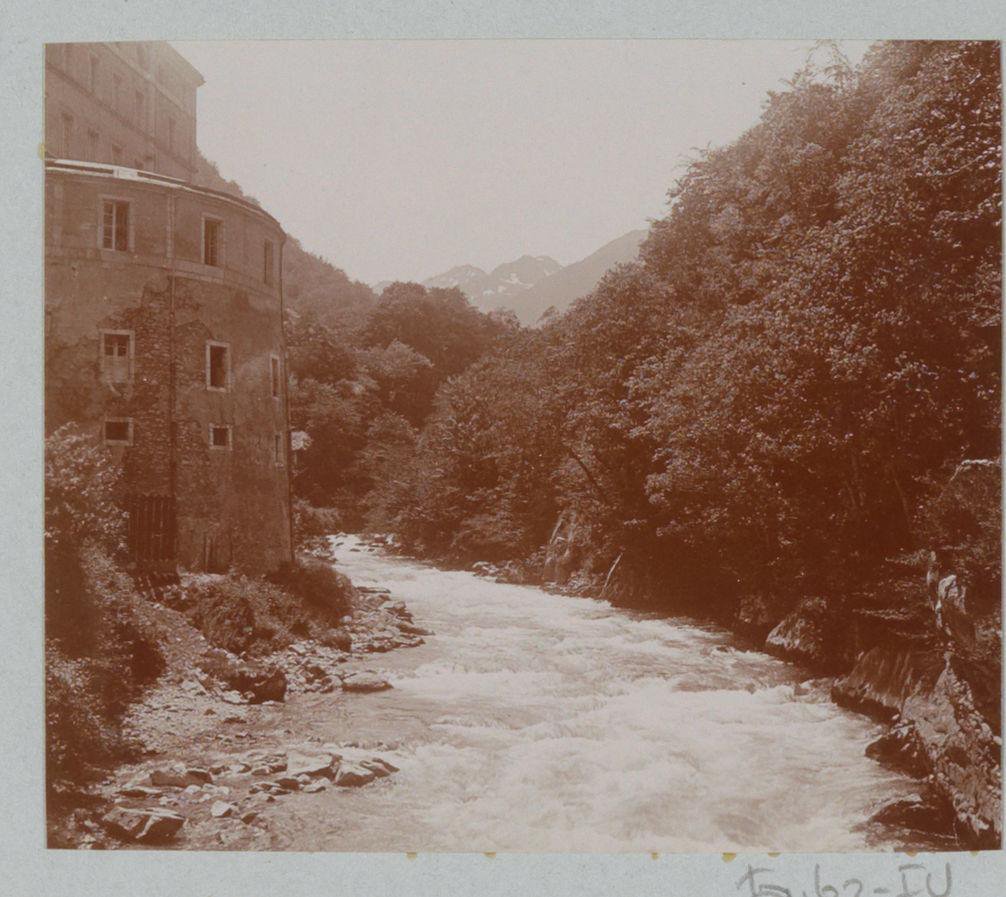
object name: photograph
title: Gebouw aan een beek, vermoedelijk in Frankrijk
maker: Anonymous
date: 1905-1910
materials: paper, photographic support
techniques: gelatin silver print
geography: france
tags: brook, mountains (+ landscape with figures, staffage), exterior ~ representation of a building, france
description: Onderdeel van Fotoalbum van een Franse amateurfotograaf met bezienswaardigheden in Frankrijk, Zwitserland en Italië.